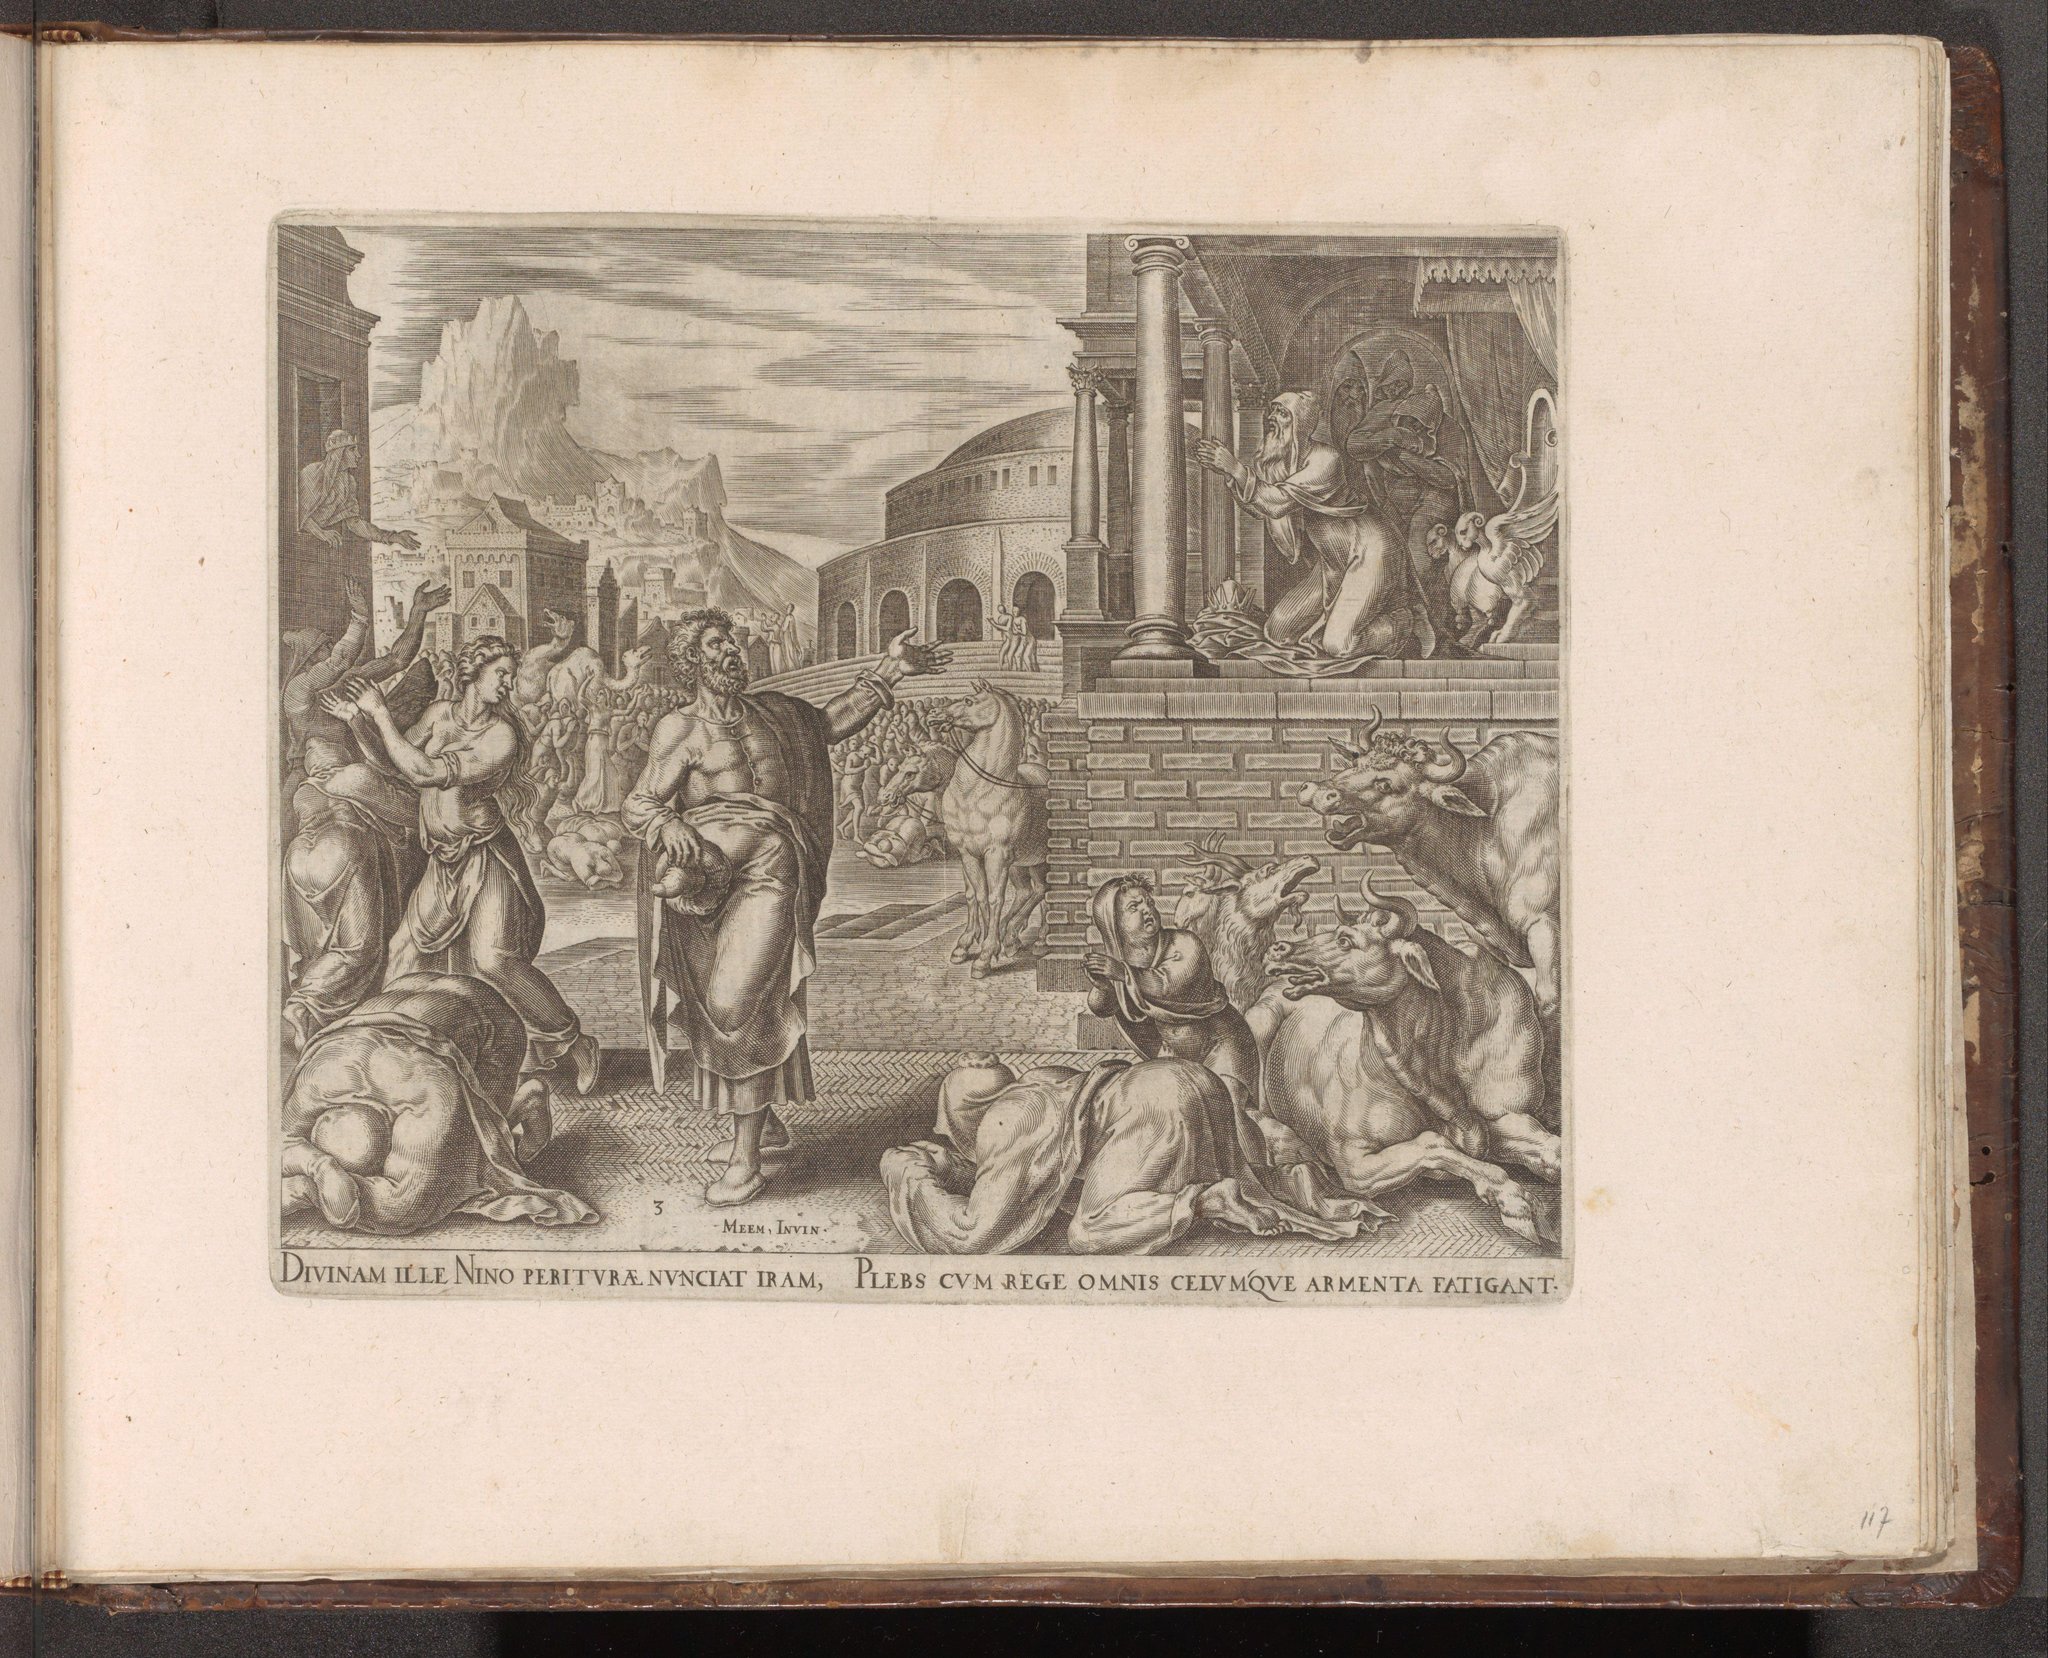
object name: print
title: Geschiedenis van Jona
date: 1566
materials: paper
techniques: engraving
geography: antwerp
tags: when jonah arrives in the city of nineveh he foretells its destruction in forty days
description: Jona staat op een plein in Nineve en voorspelt de inwoners de ondergang van hun stad. De mensen knielen van verschrikking en berouw. Onder de voorstelling een verklarende tekst in het Latijn. Prent maakt deel uit van een album.